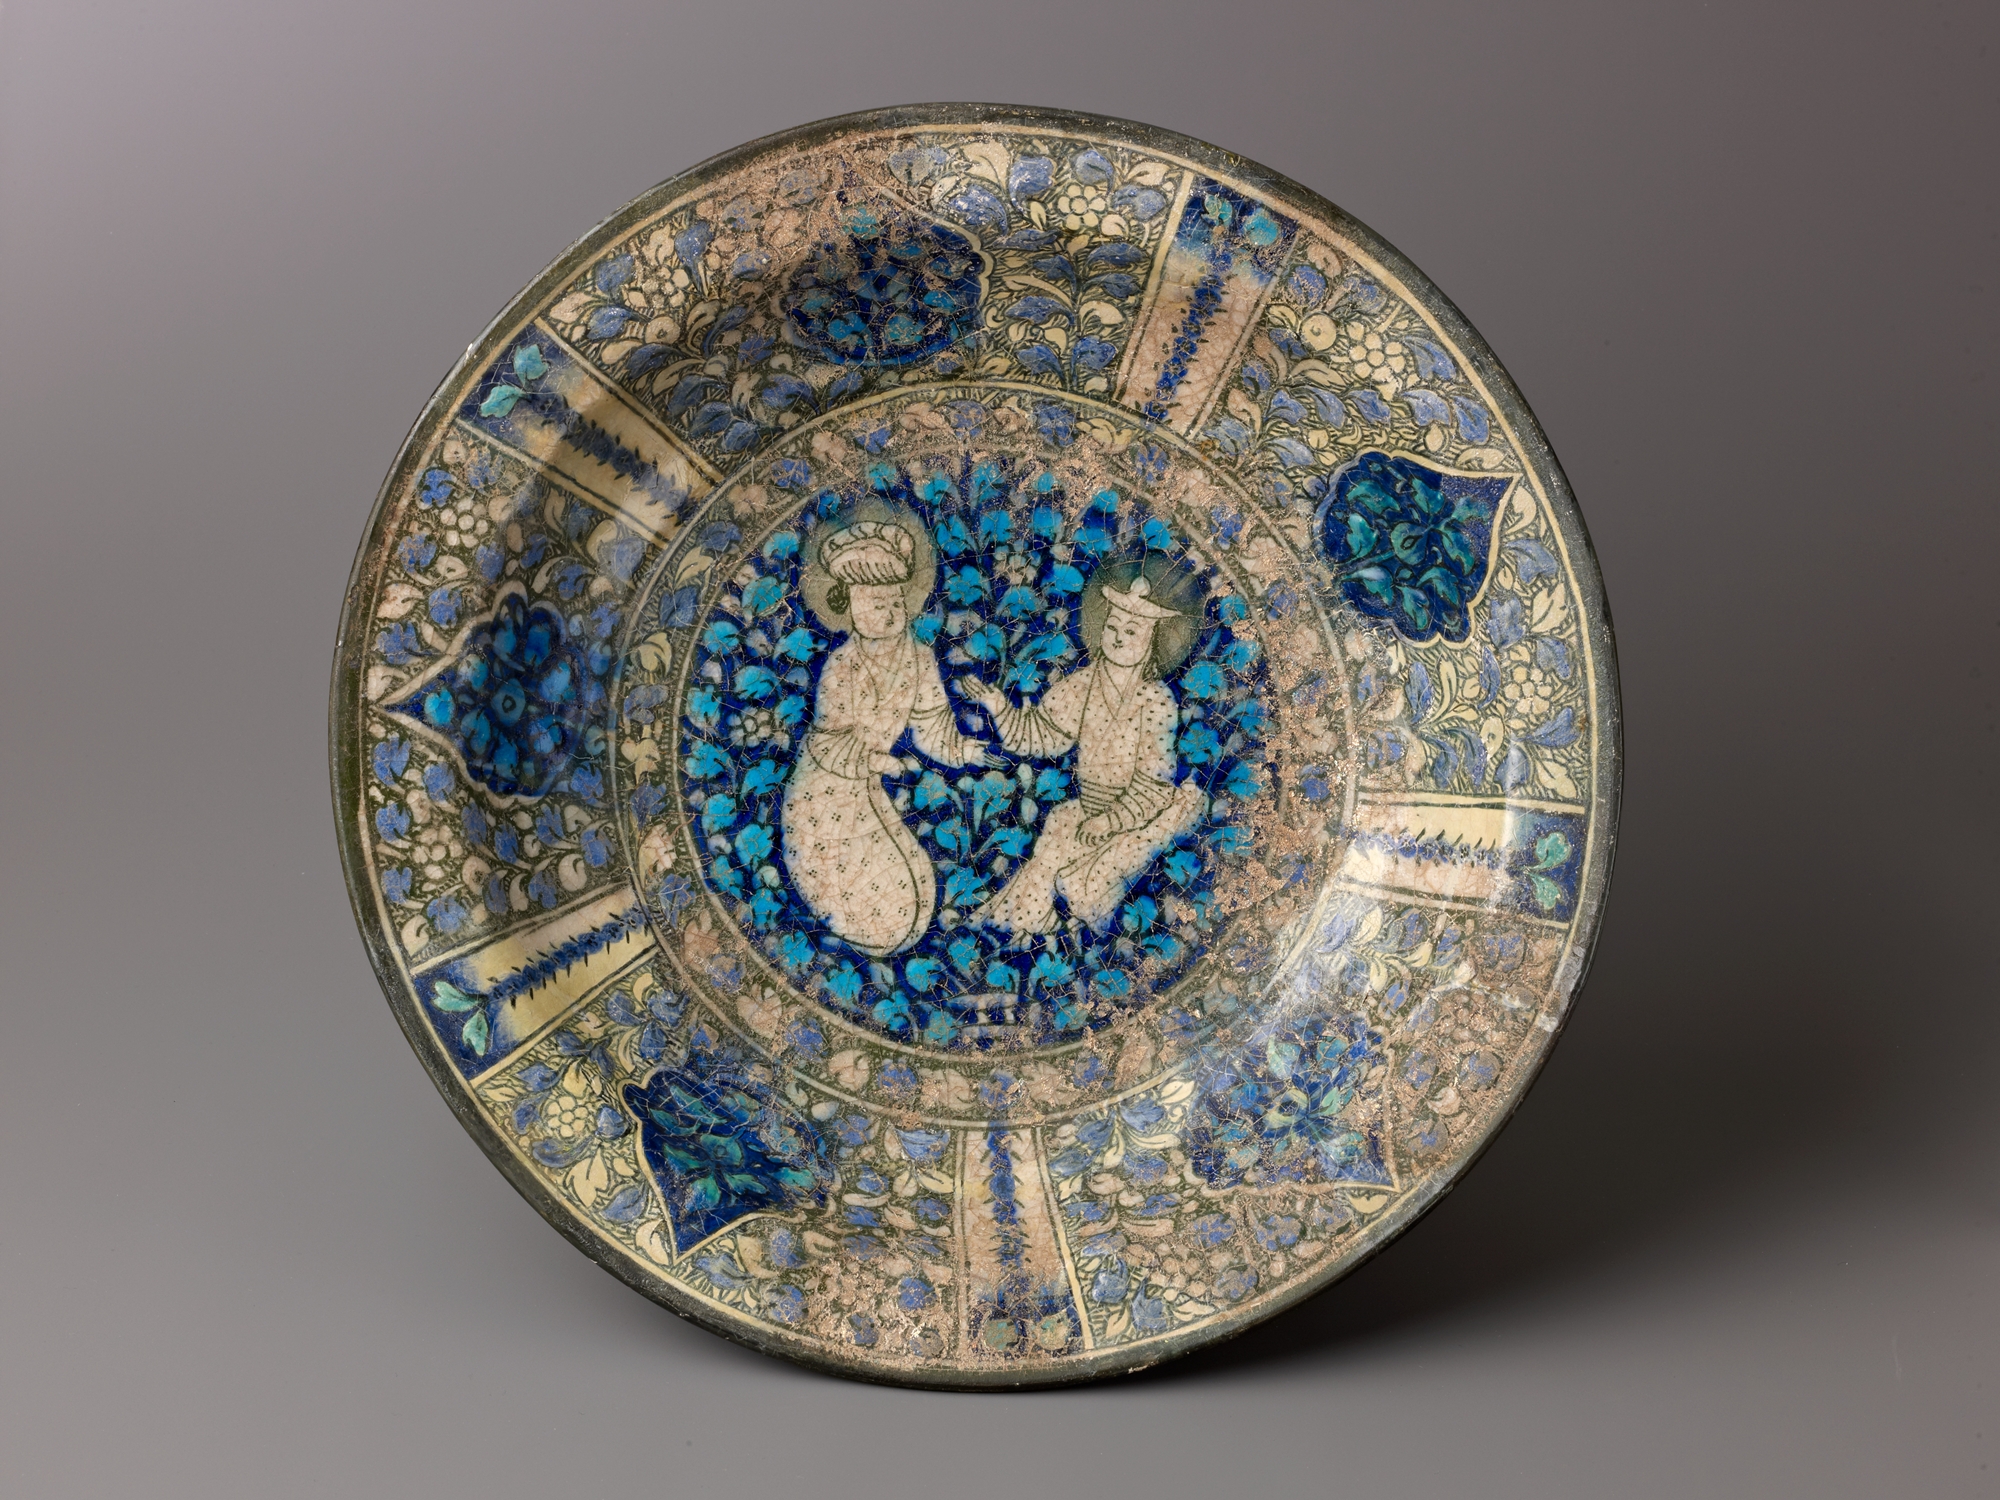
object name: bowl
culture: iranian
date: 1301-1350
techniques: painting, underglaze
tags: men,flowers